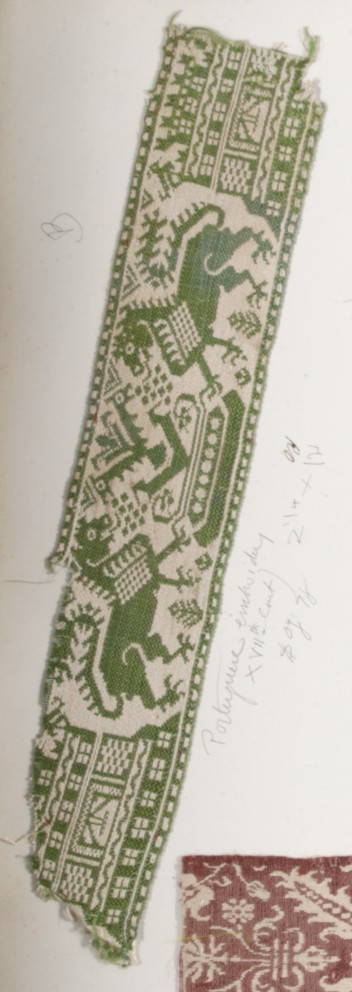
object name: fragment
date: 1601-1700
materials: silk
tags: horses